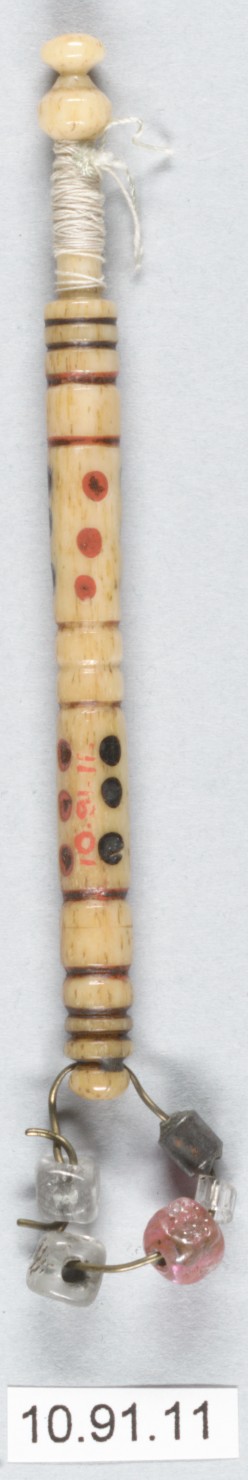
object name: bobbin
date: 1801-1900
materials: bone, metal